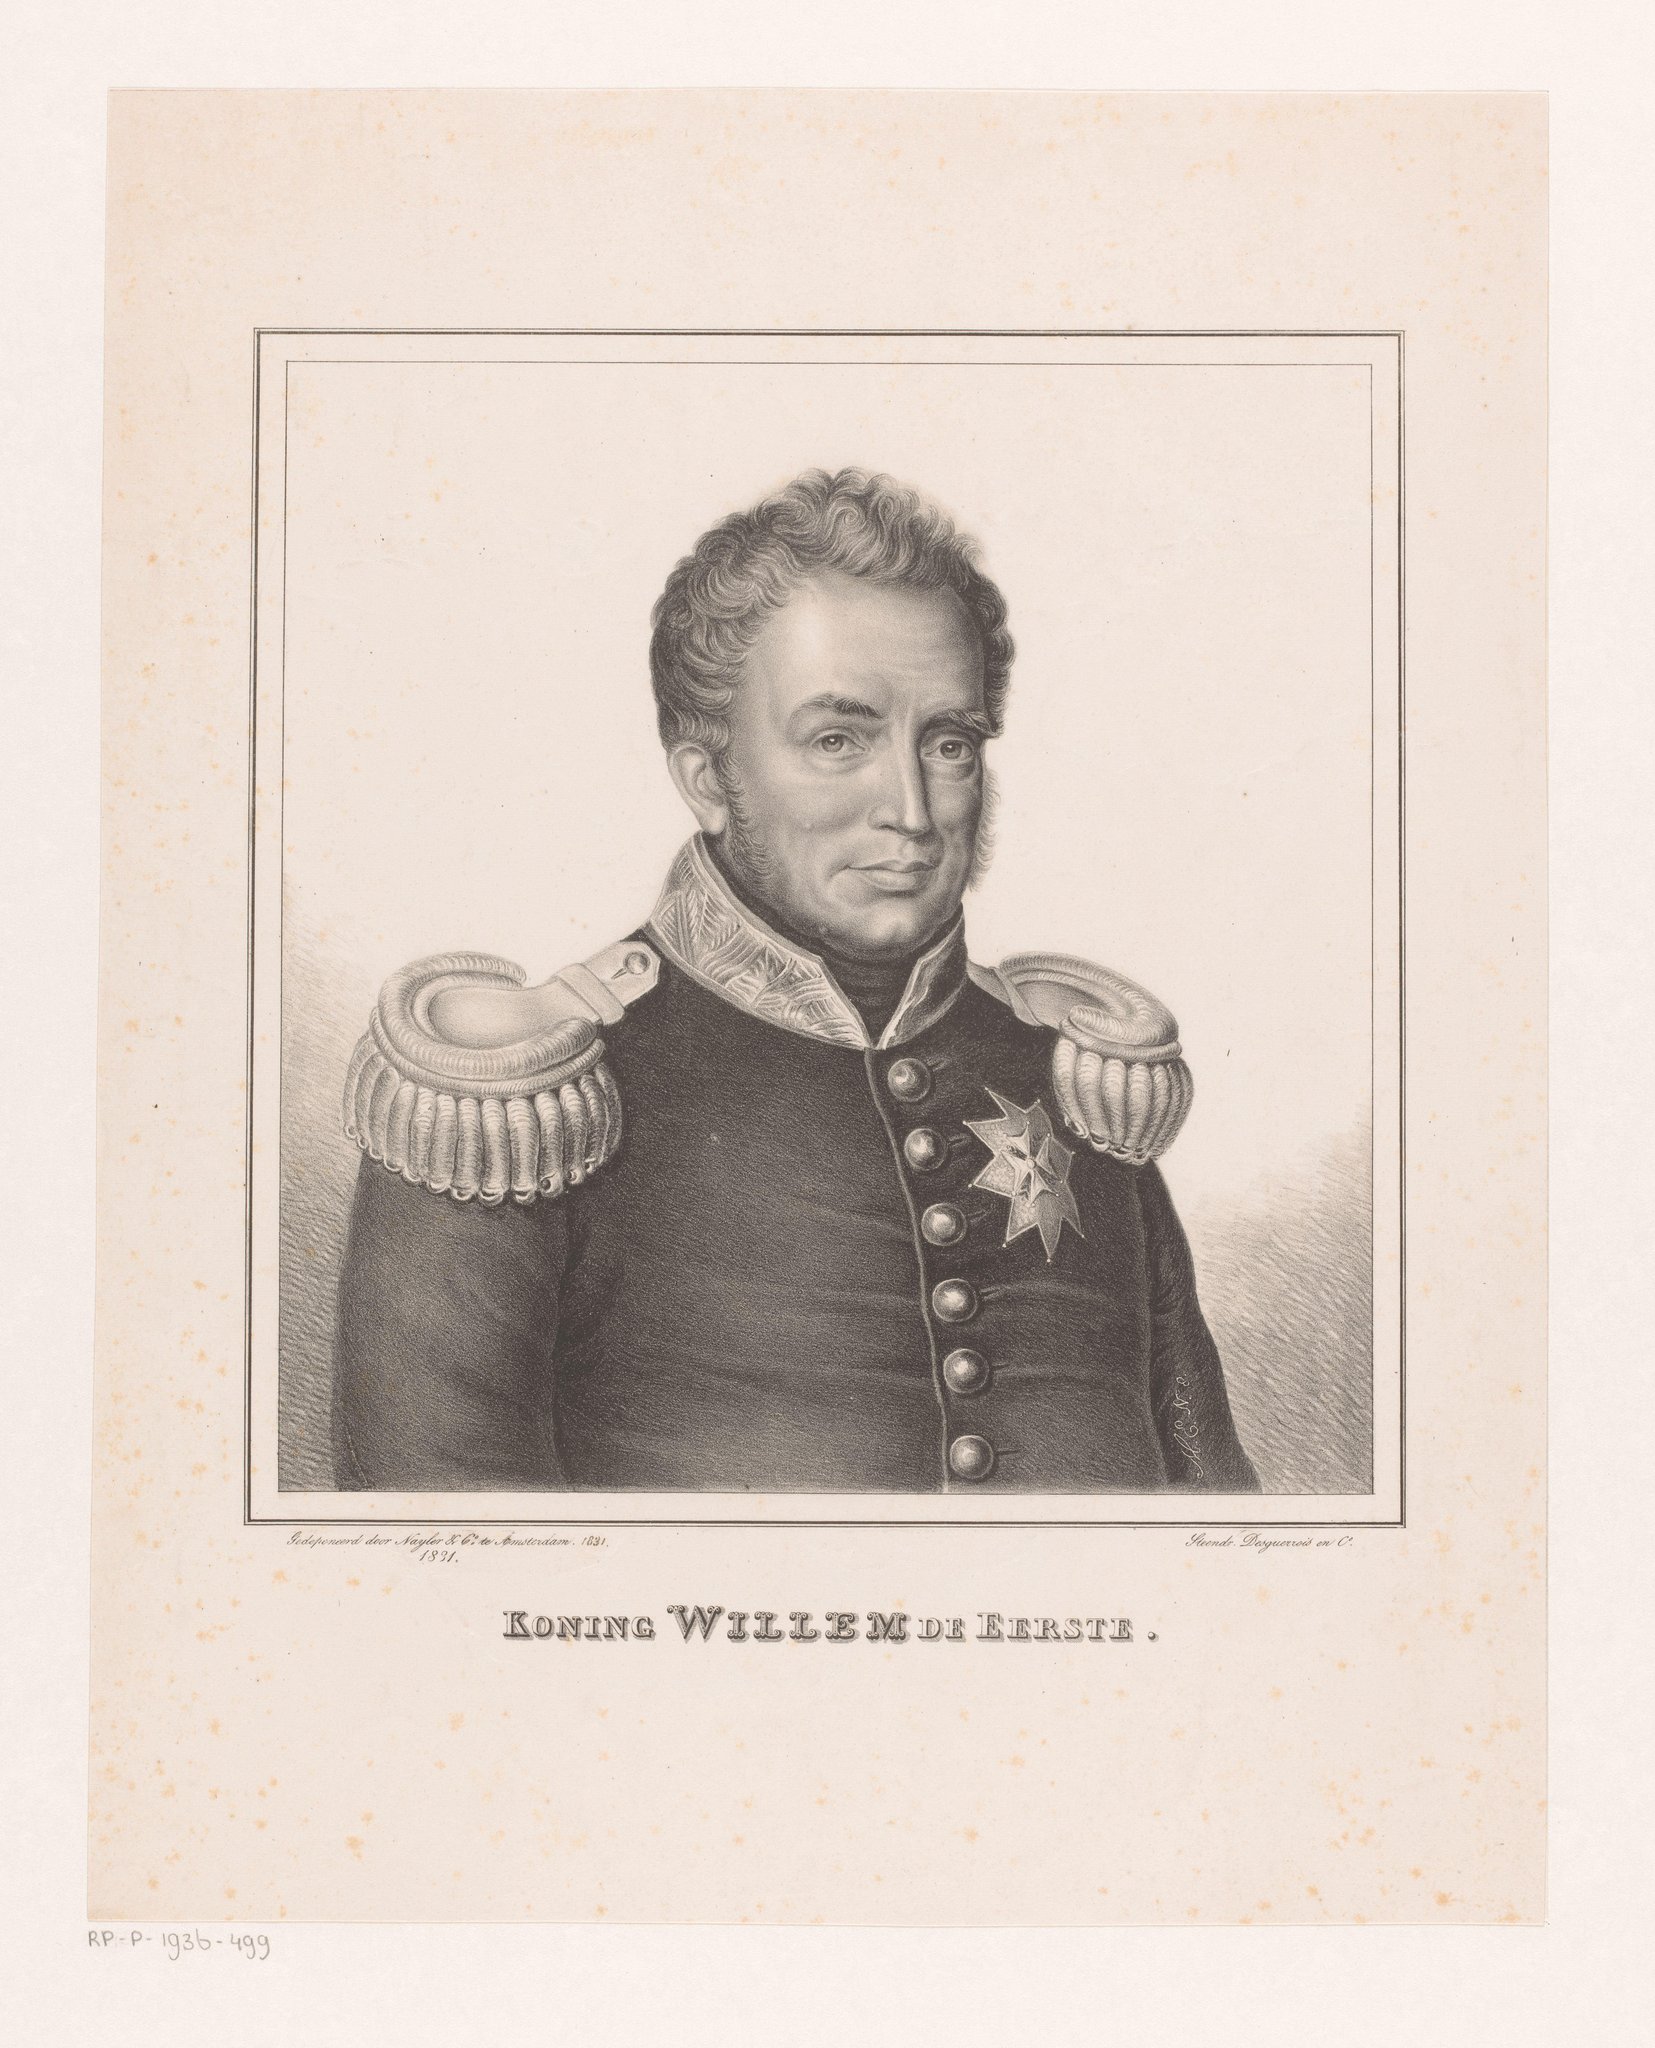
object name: print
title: Koning Willem de Eerste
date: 1831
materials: paper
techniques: lithograph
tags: the hague, berlin, william i of the netherlands, historical persons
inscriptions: collector's mark: Lugt 2228, : ‘Gedeponeerd door Nayler & Co te Amsterdam / 1831’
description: Genummerd in signatuur. Zie ook RP-P-1906-1239 en RP-P-1910-1248.